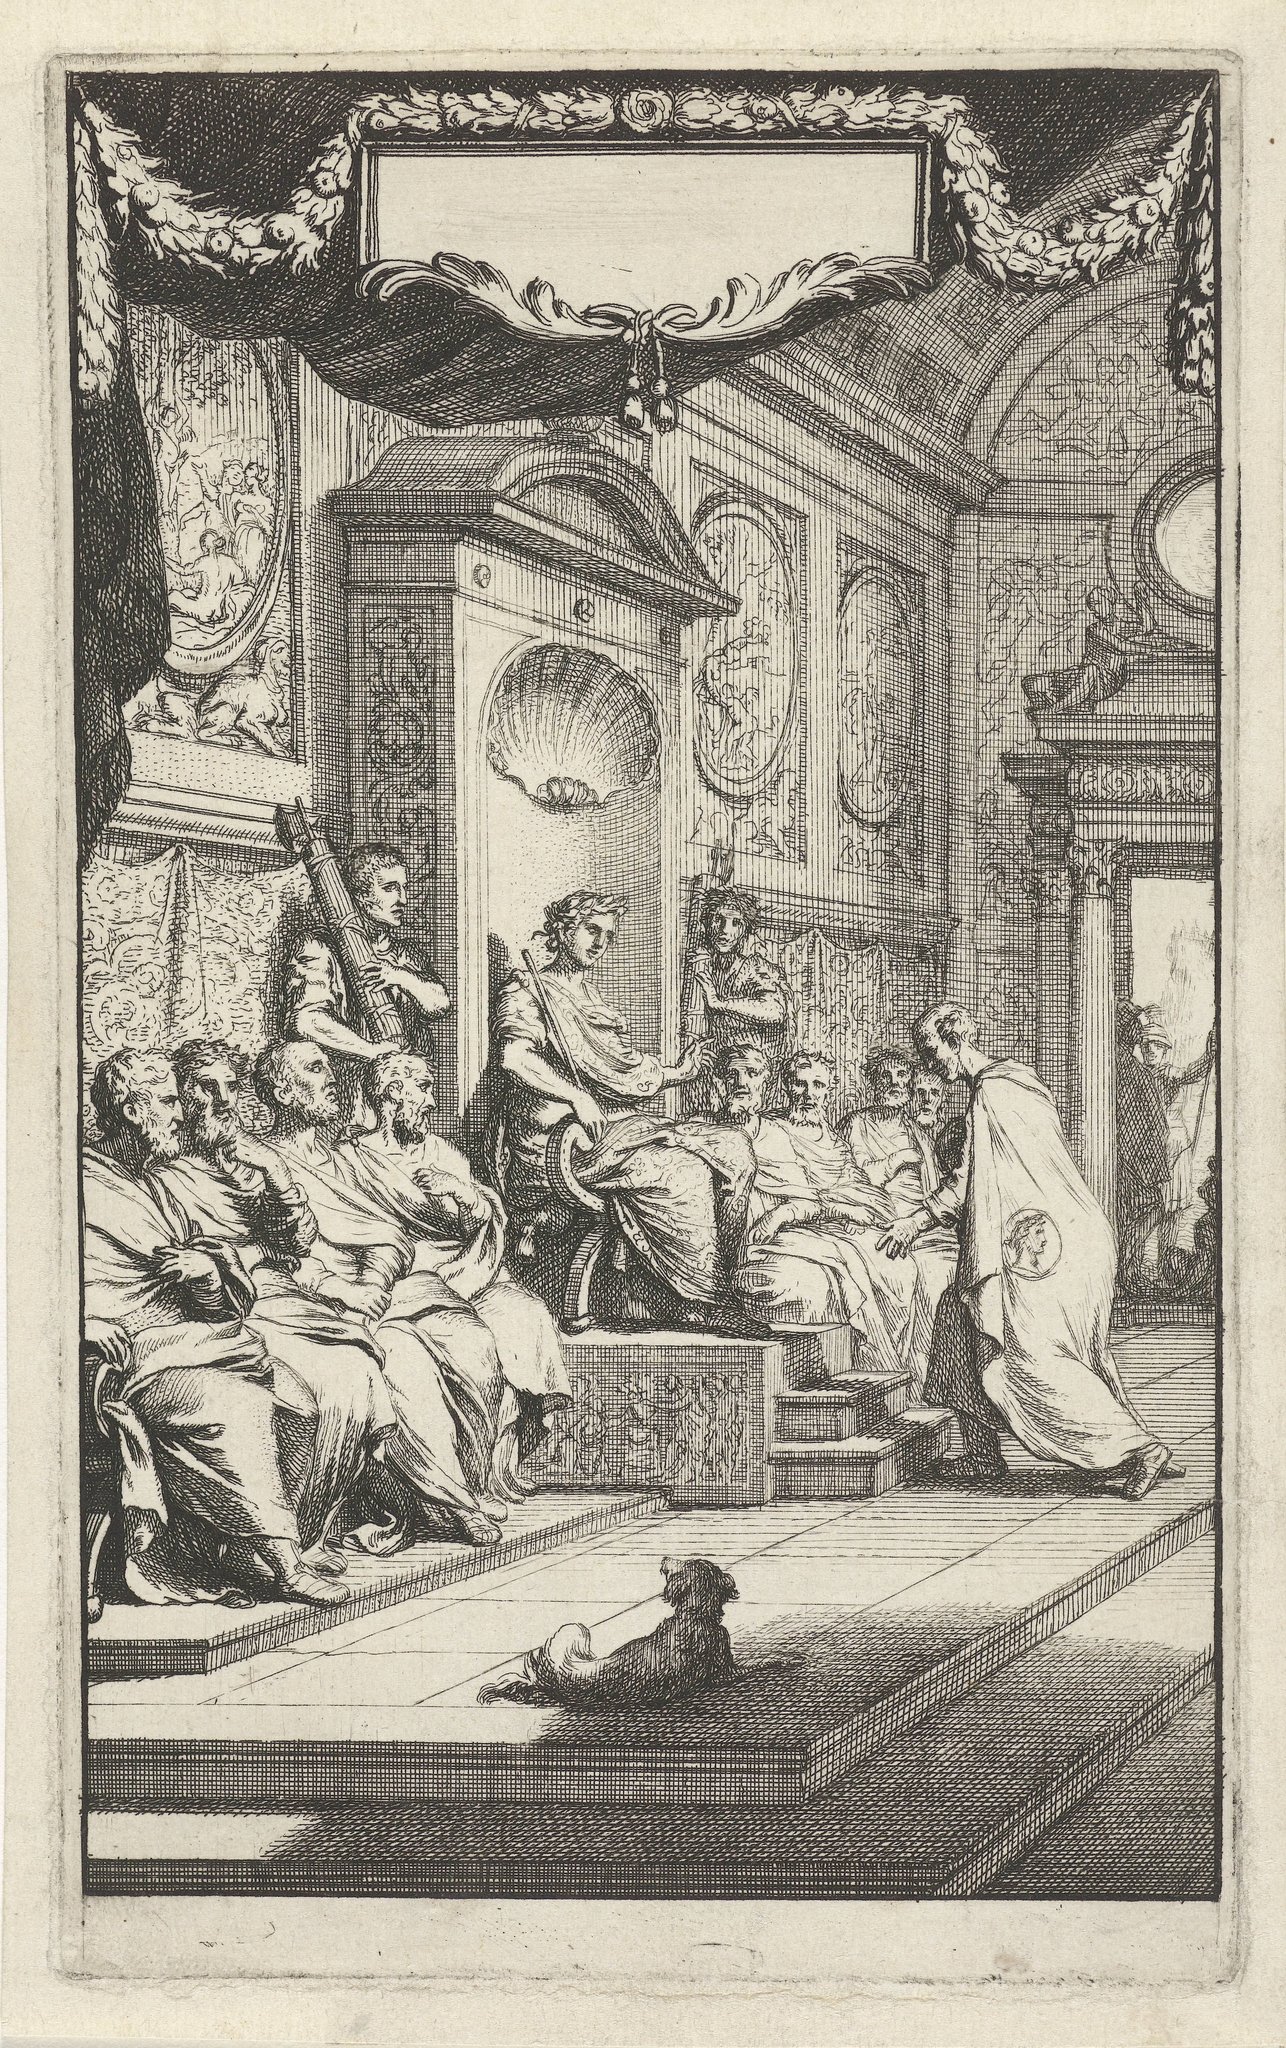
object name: print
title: Romeinse consul geflankeerd door twee lictoren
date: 1600-1699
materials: paper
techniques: etching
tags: law and jurisprudence (+ 'fasces cum securibus'), head bent forward; bowing, ruler, sovereign, dog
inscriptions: collector's mark: Lugt 240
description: Een tronende Romeinse consul wordt geflankeerd door twee lictoren die beide een fasces vasthouden, symbool van de rechtsmacht van ambtenaren. Aan weerszijden van de troon zitten senatoren. De consul begroet een figuur die voor hem buigt, op de voorgrond ligt een hond.